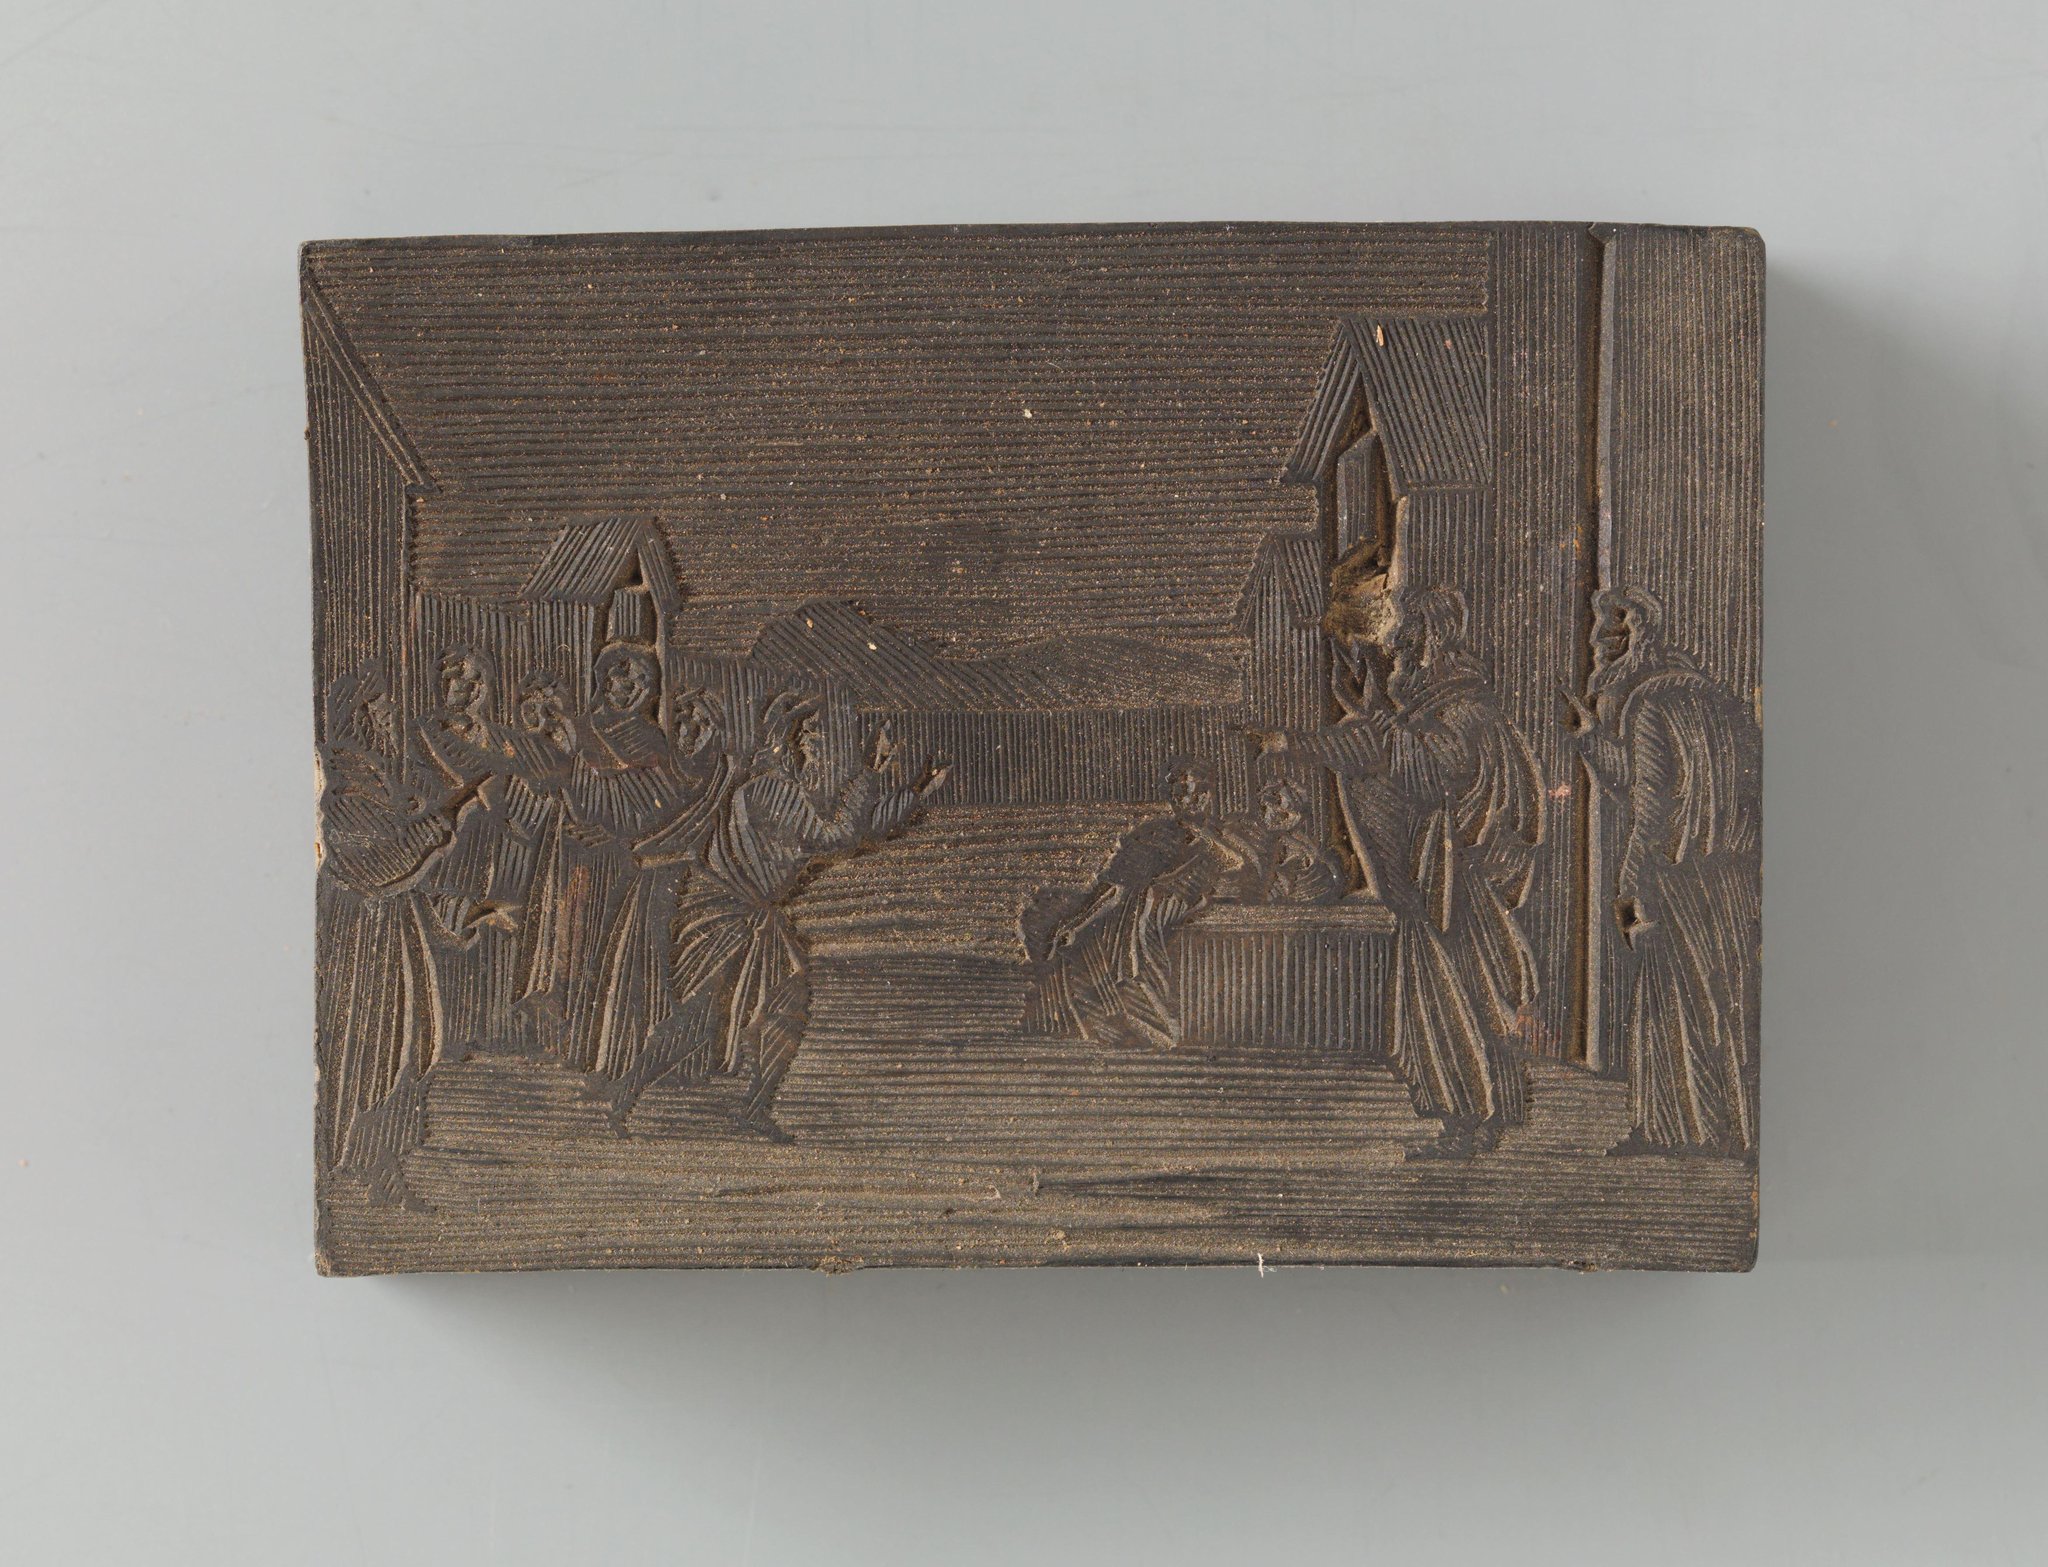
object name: wood block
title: Bijbel-illustraties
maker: Anonymous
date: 1550-1699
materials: wood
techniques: woodcut